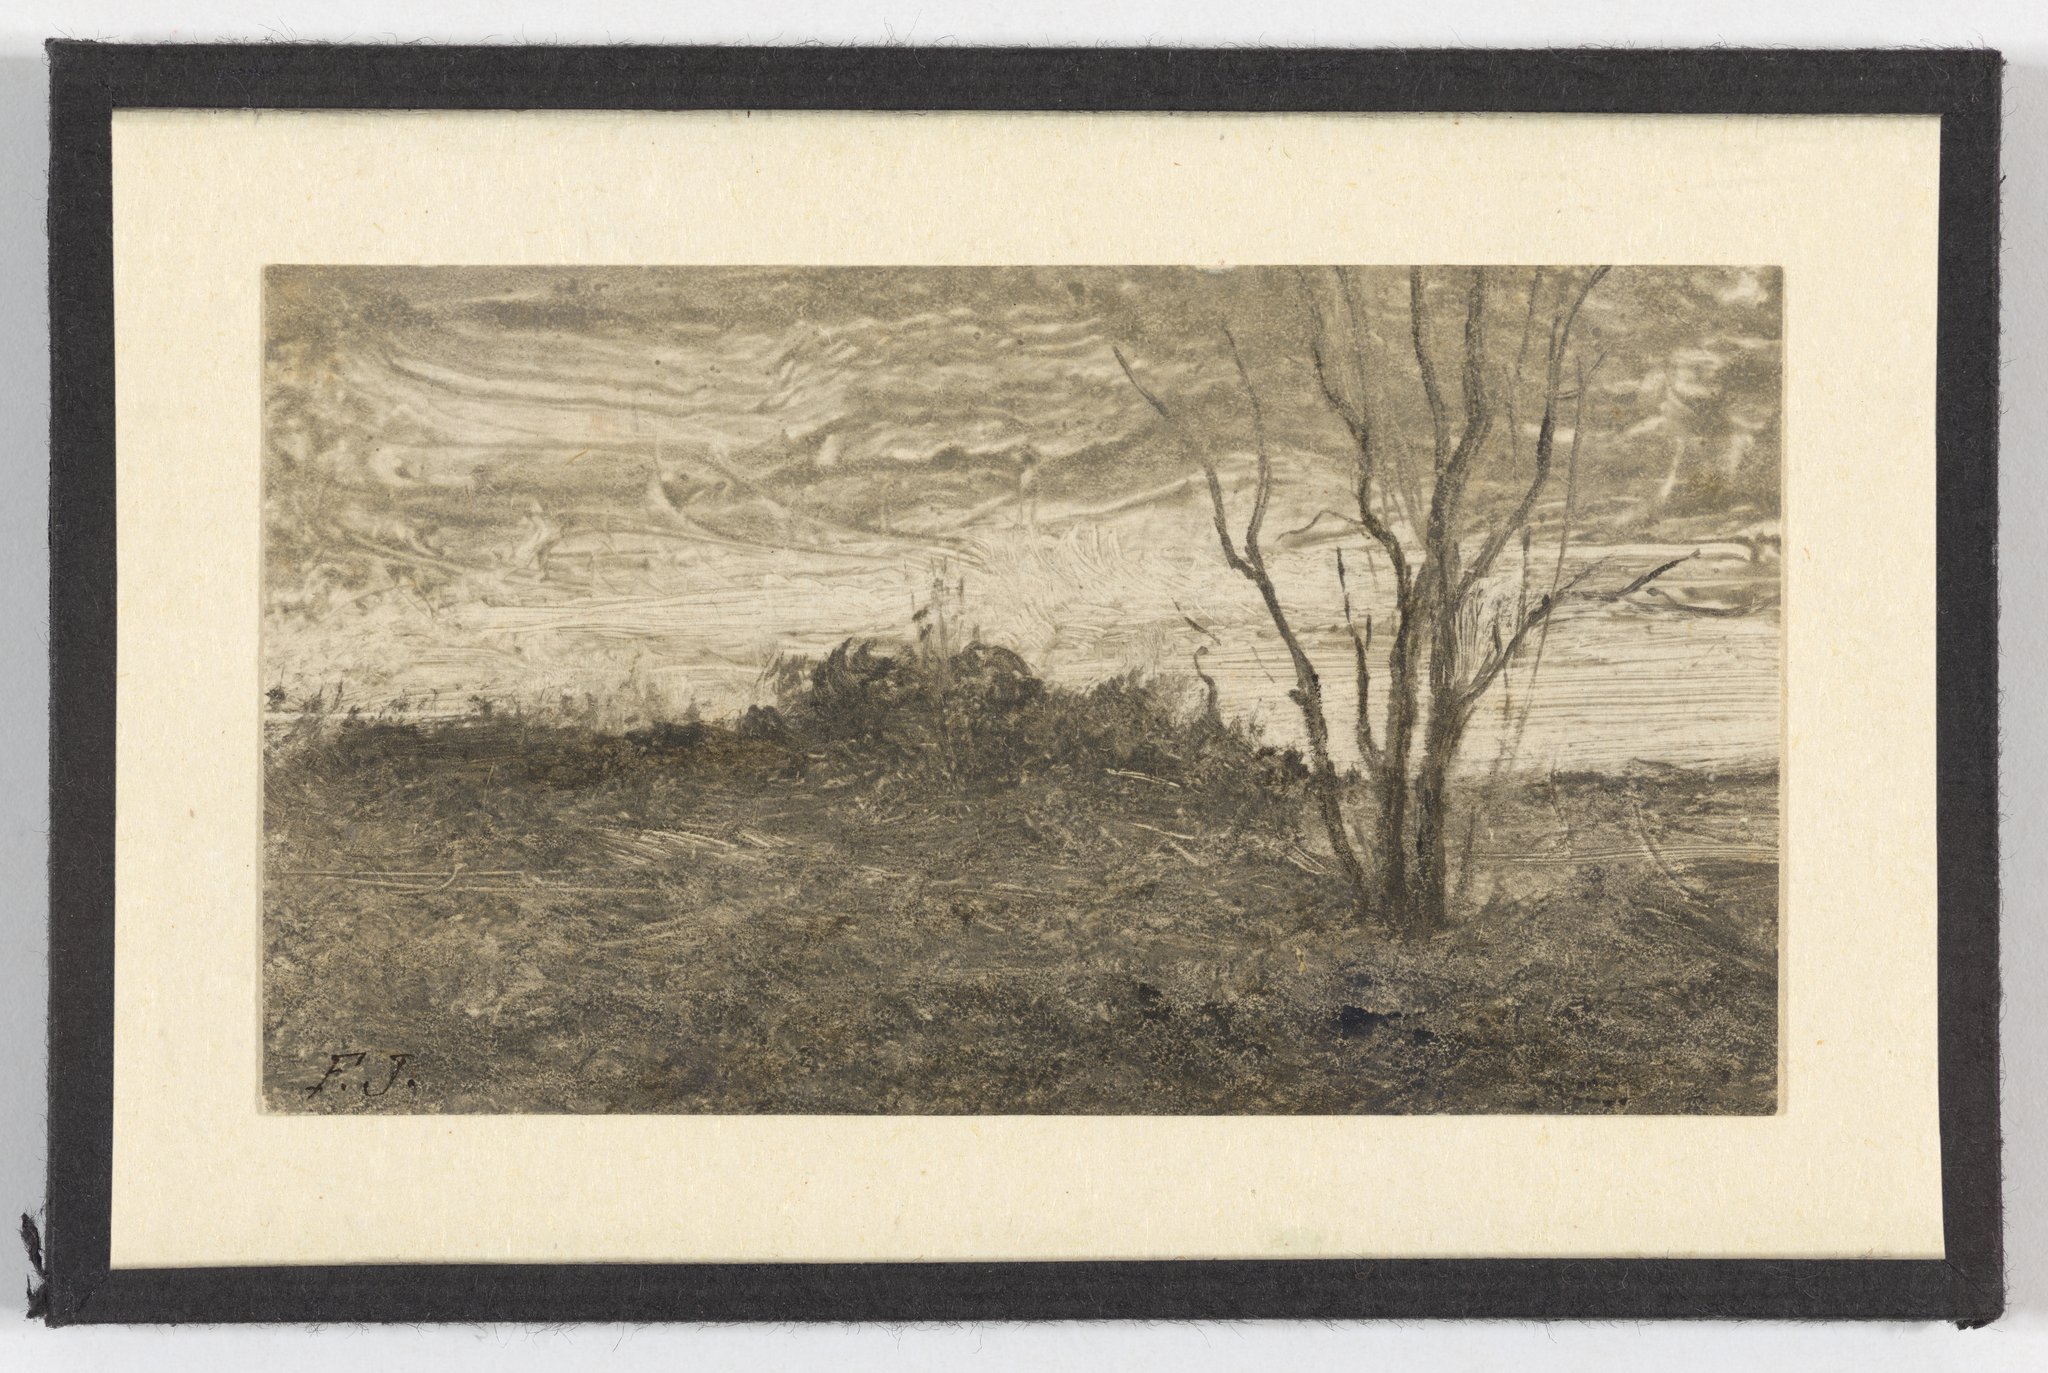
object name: drawing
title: Landscape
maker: frédéric juncker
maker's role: artist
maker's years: 1822-1906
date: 1880-1885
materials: paper, wax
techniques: brush, scraping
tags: landscapes